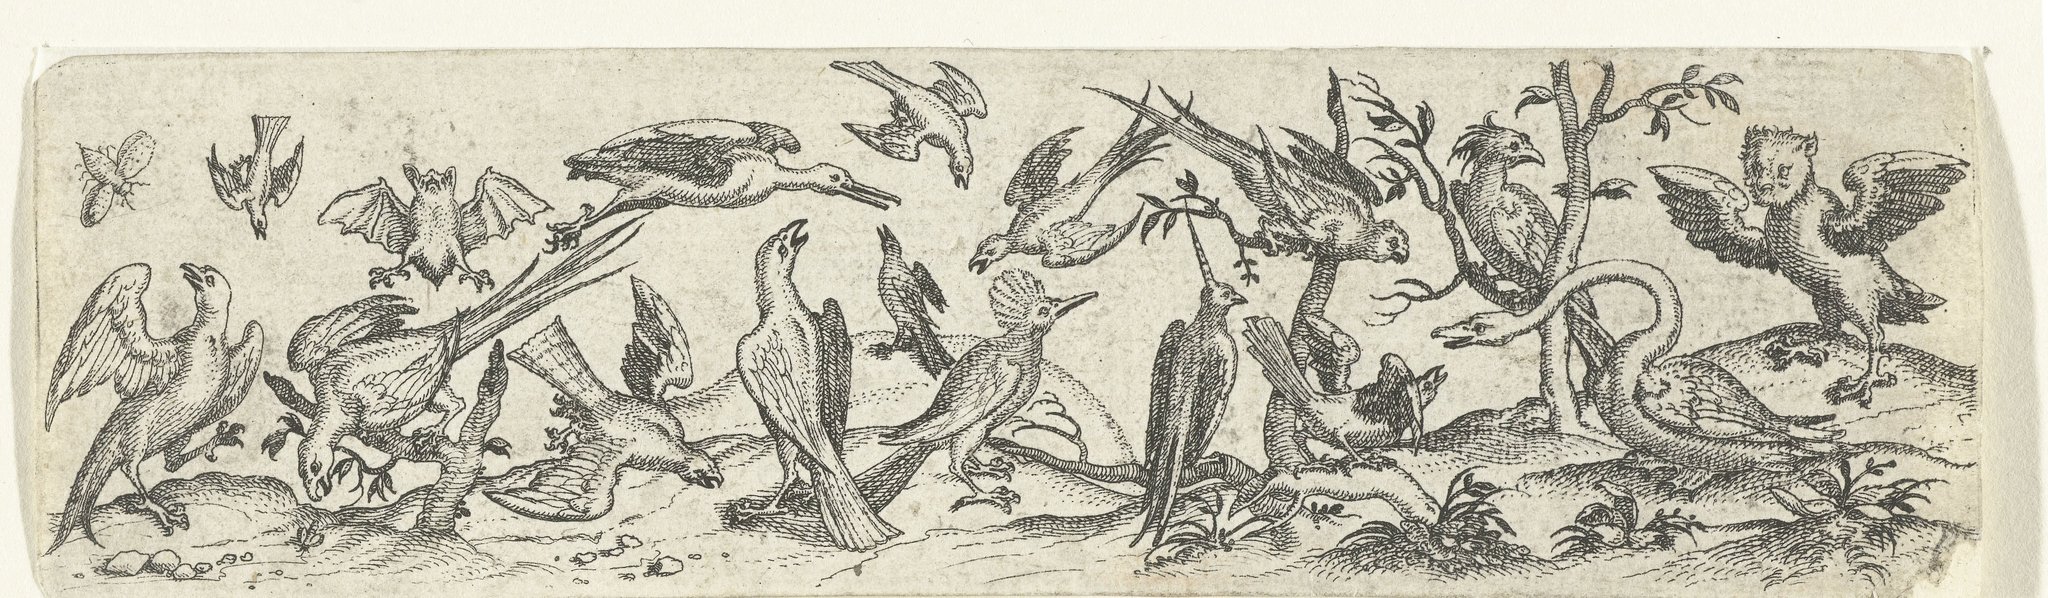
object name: ornament print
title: Fries met vogels, waaronder gans en vleesmuis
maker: Anonymous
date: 1500-1600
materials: paper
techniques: engraving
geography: netherlands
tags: water-birds: goose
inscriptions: inscription: ‘8’, inscription: ‘Tbz Brz.(?) Friezes of birds’, inscription: ‘H. Liefrinck? Serwouten?’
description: Rechts een uil, aan de linkerkant een vleermuis die naar boven kijkt.